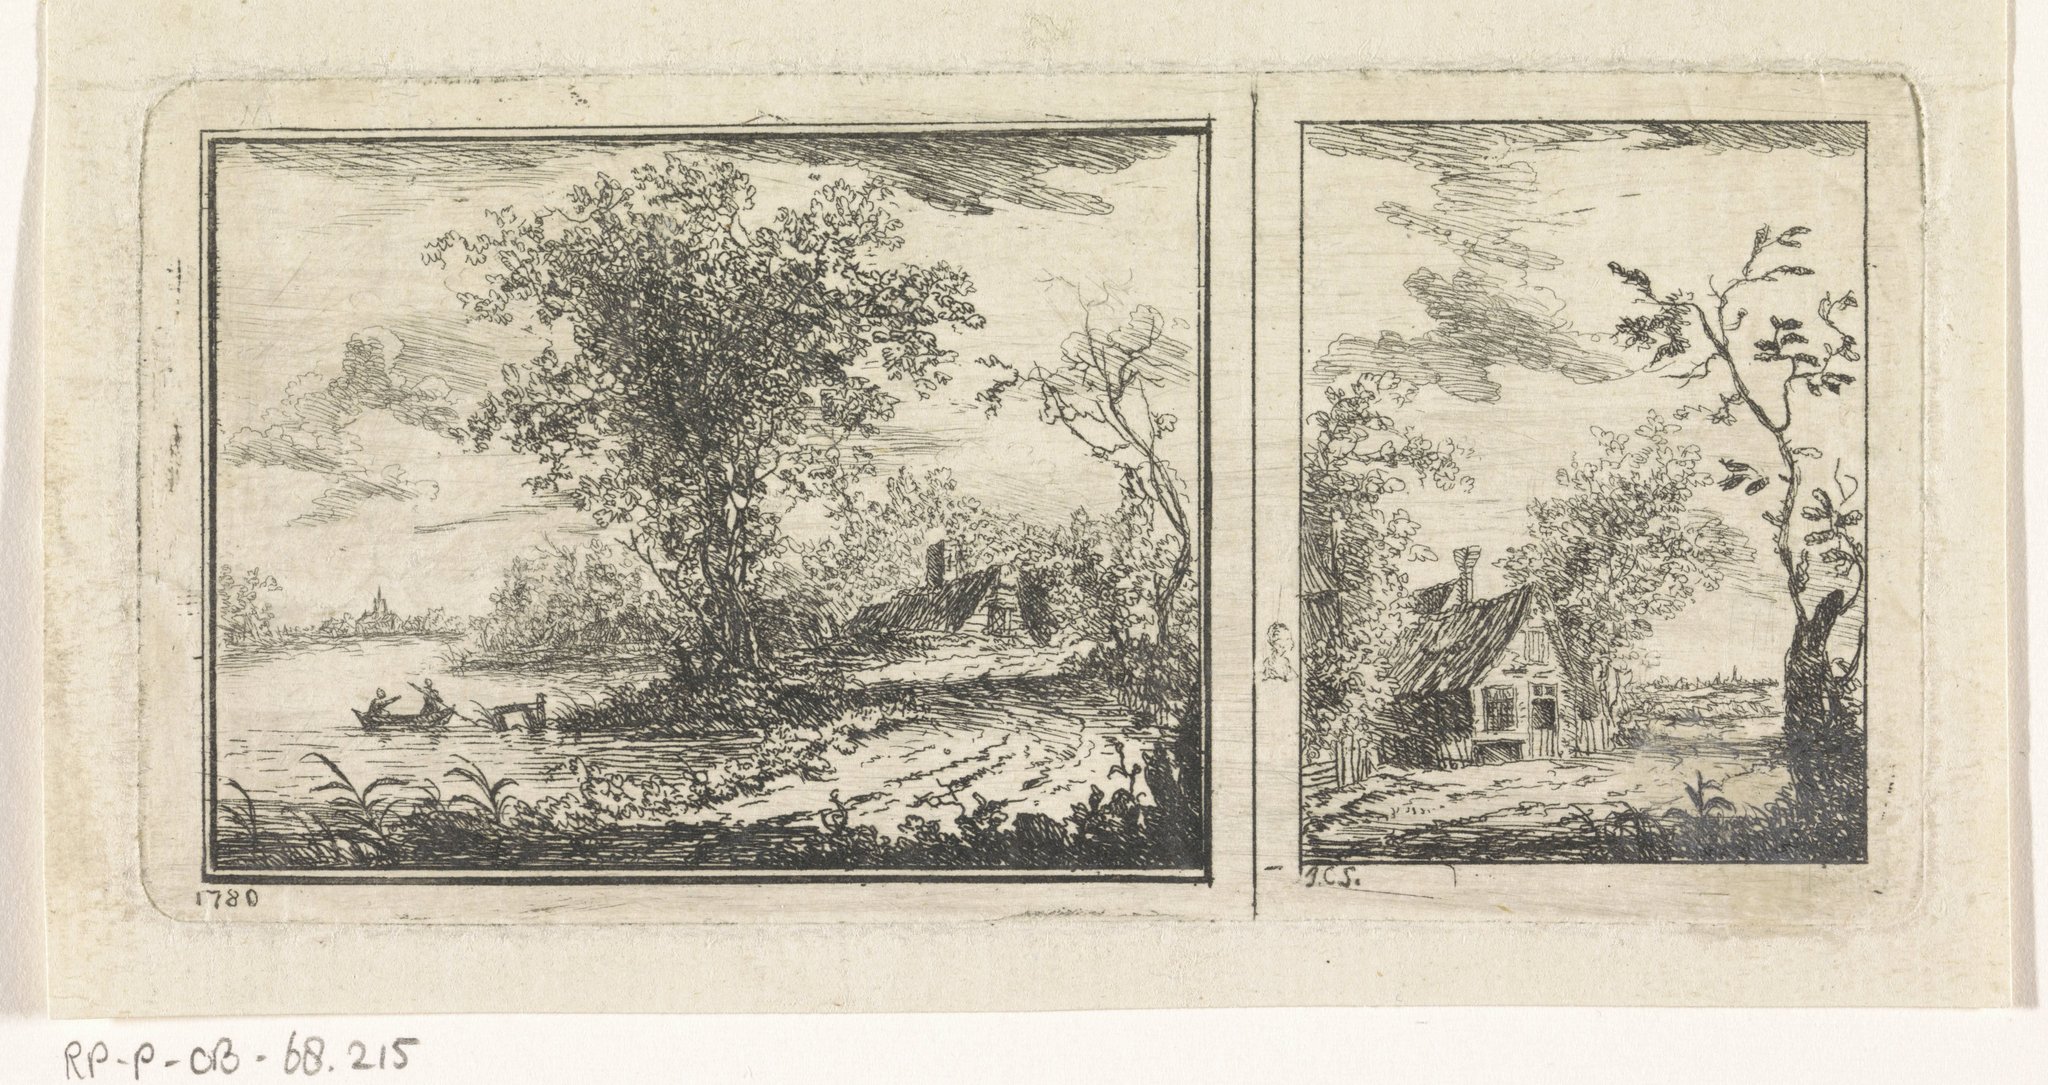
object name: print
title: Rivierlandschap en woning in landschap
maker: monogrammist jcs (graveur)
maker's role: print maker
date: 1780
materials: paper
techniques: etching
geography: netherlands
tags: river, farm or solitary house in landscape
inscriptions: collector's mark: Lugt 2228, inscription: ‘Cato / HTvB’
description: Twee voorstellingen. Links een rivierlandschap met een roeiboot op de rivier en rechts een weg. Rechts een woning in een landschap.